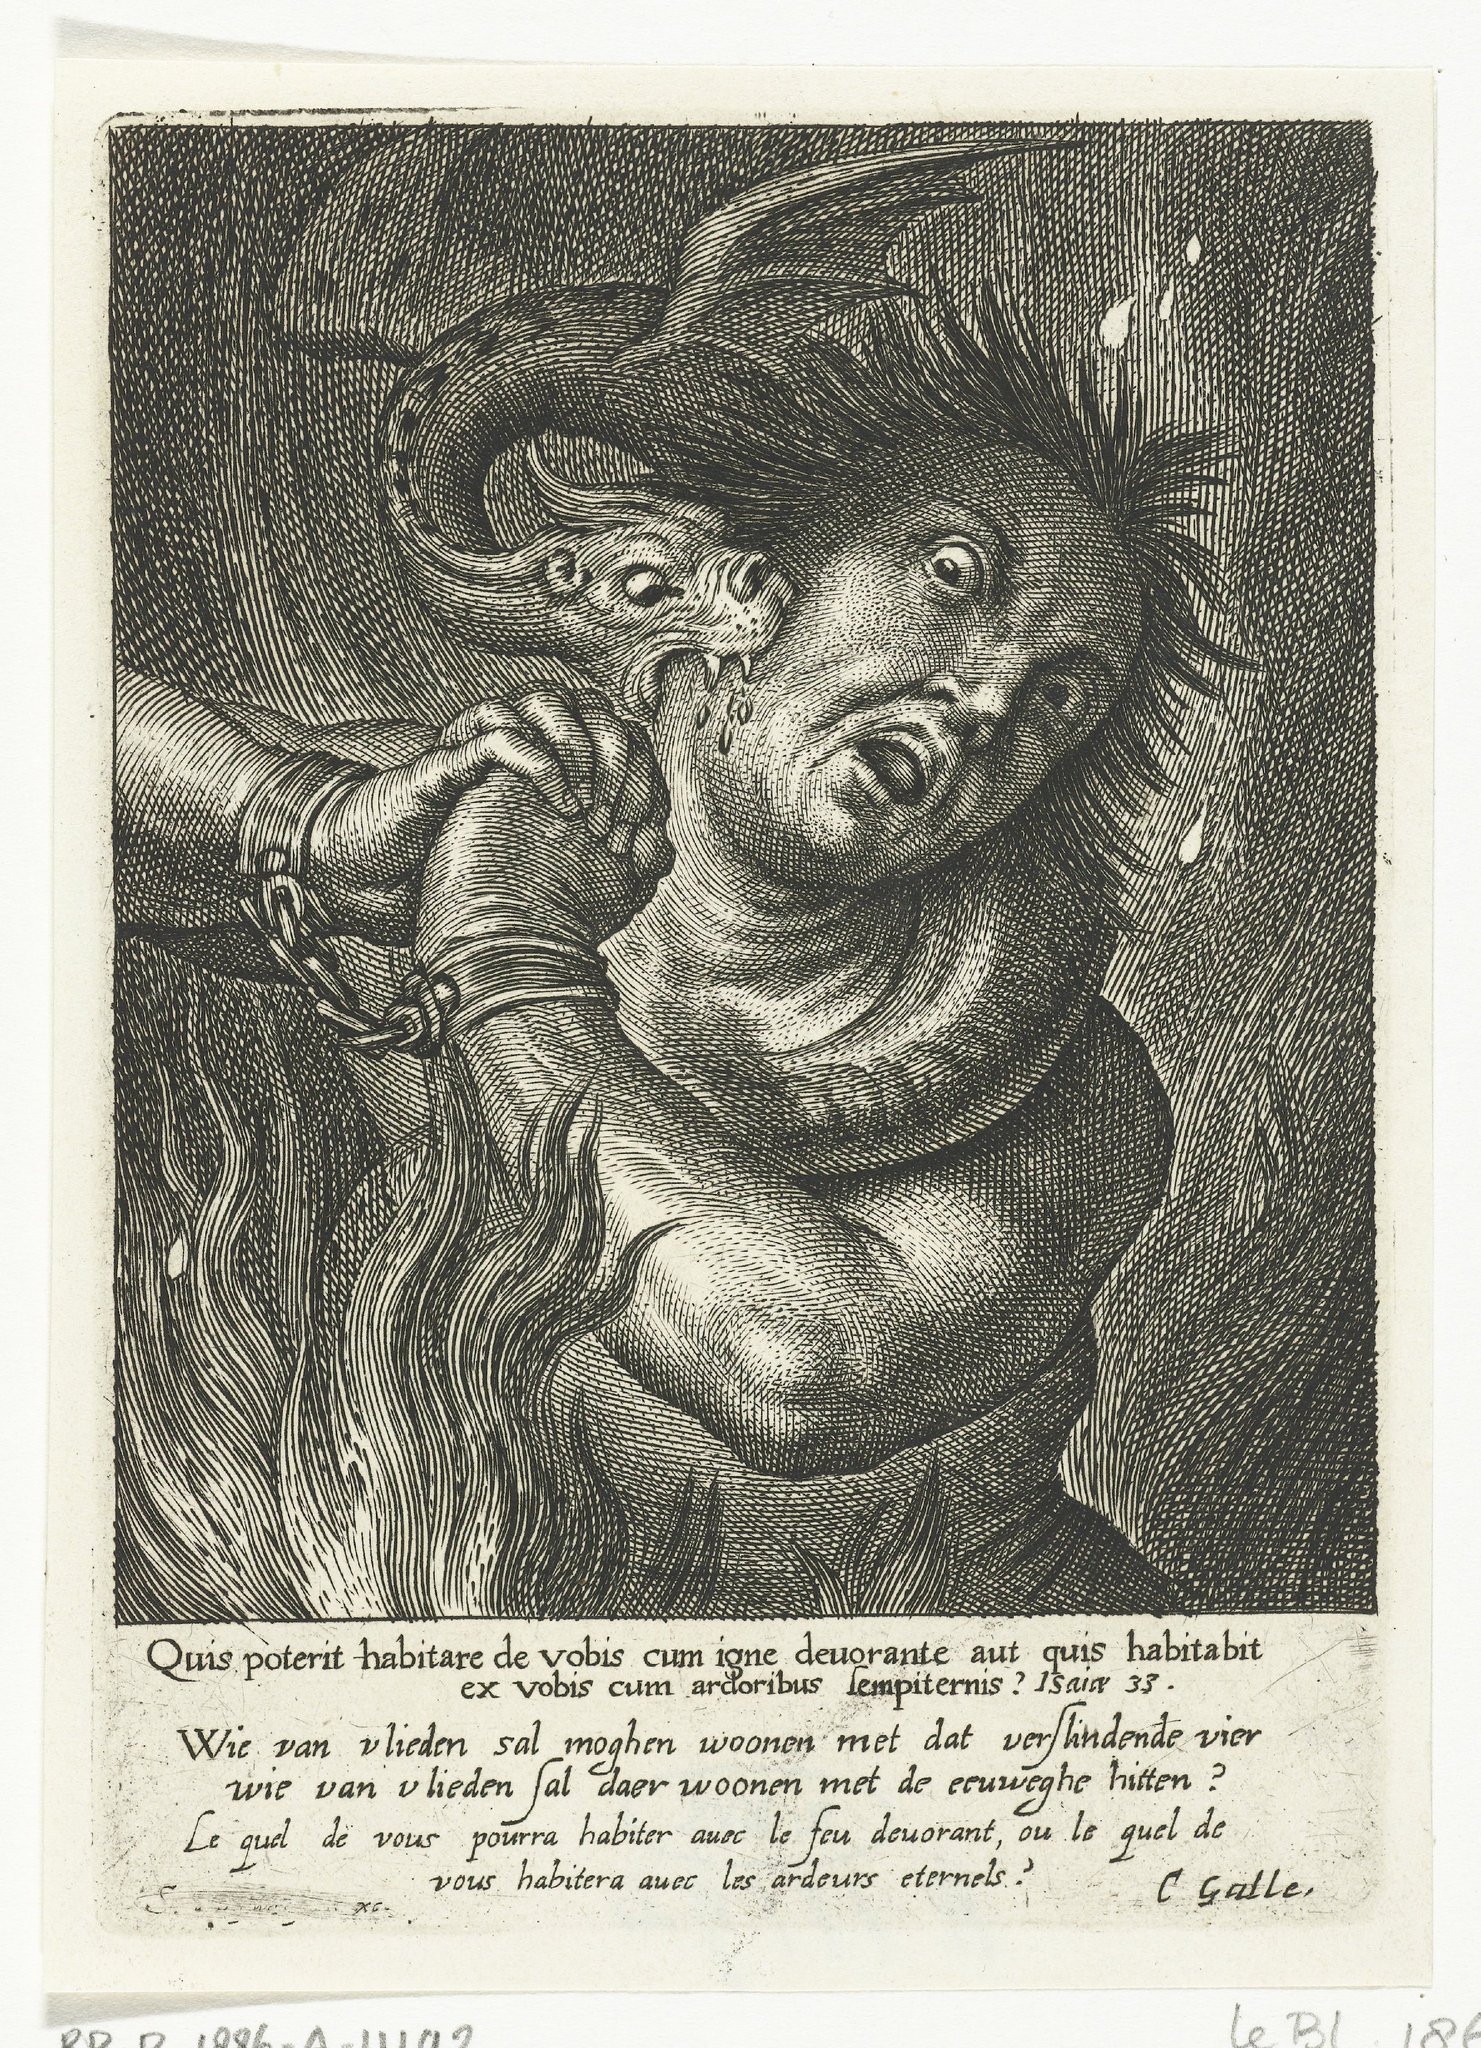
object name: print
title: Vélins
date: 1596-1678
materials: paper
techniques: engraving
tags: the damned souls beaten, pricked, scourged, etc. by devils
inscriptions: collector's mark: Lugt 2228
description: Prent uit serie Vélins met negentig prenten naar ontwerp van Peter Paul Rubens. In de bronnen vinden we uiteenlopende gegevens over aantal en samenstelling van de serie. Hollstein hanteert het aantal van negentig prenten. De reeks Vélins in de collectie van het RMA bevat verschillende staten afkomstig uit meerdere uitgaven welke moeilijk te duiden zijn. Sommige dragen het originele adres van Schelte Adamsz. Bolswert als graveur en uitgever, op andere exemplaren is deze naam verwijderd (duidelijk zichtbaar!) en vervangen door de naam Cornelis Galle (II). De prenten met de naam van uitgever Galle zijn vaak opgewerkt. We treffen nog een andere naam van een uitgever bij enkele prent aan: Martien van den Enden. Herkomst uit meerdere uitgaven spreekt ook uit afwijkende opschriften in Nederlands en Latijn en variaties op dezelfde thema's welke misschien nooit langs elkaar in dezelfde serie gebruikt werden.